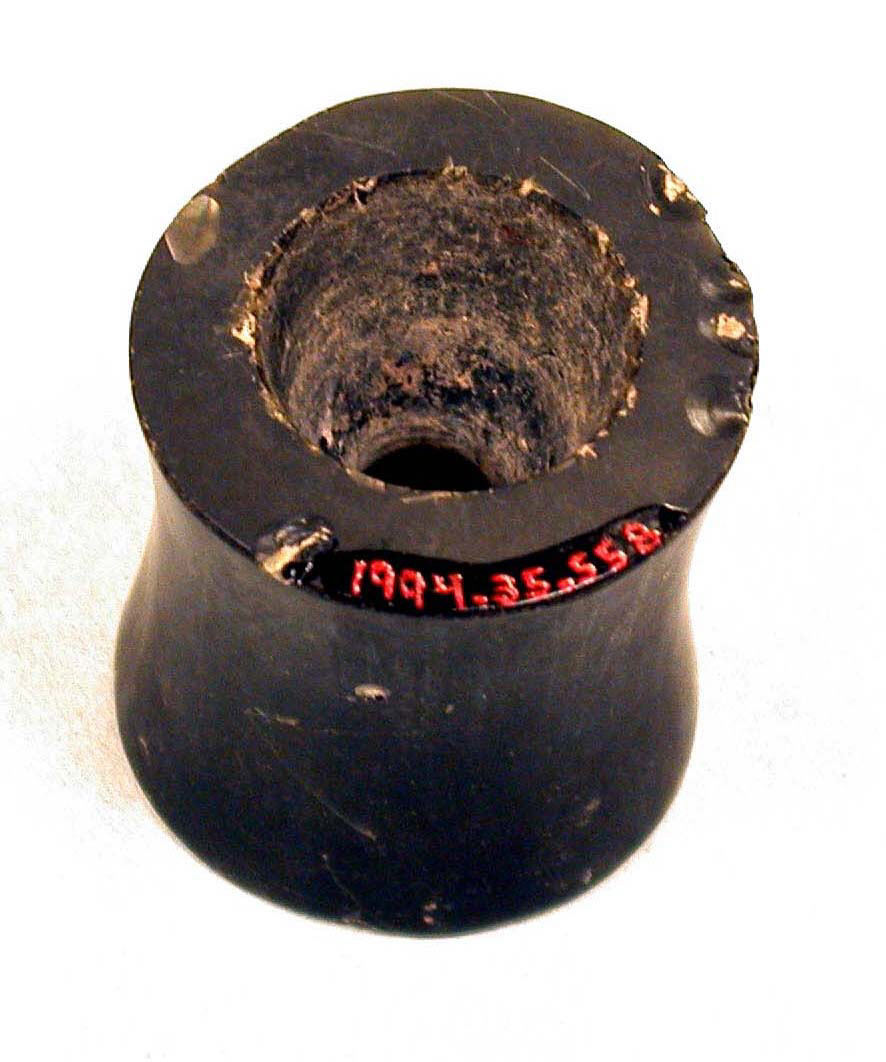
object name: ear spool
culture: mexican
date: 1501-1600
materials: obsidian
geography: mexico